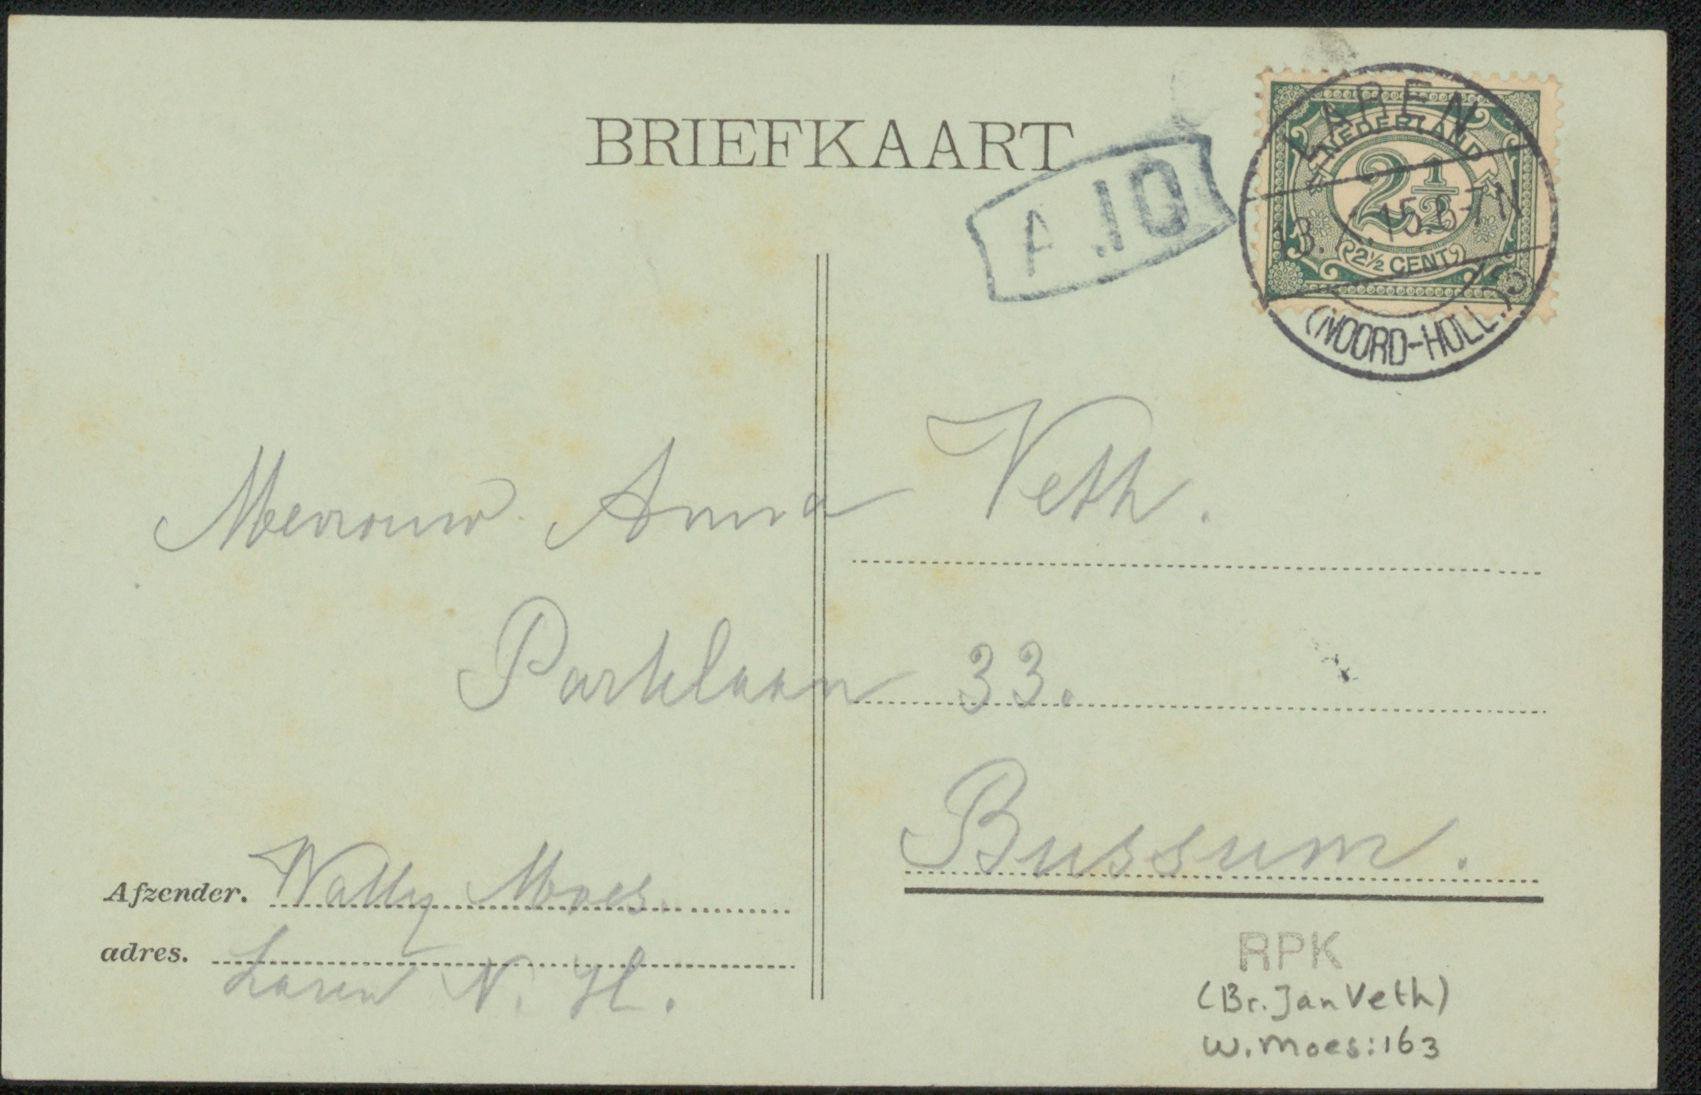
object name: postcard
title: Briefkaart aan Anna Dorothea Dirks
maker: wally moes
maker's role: draughtsman, print maker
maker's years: 1856-1918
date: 1915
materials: cardboard, pencil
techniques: writing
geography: laren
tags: the hague, painter, print maker, draughtsman, hendrik willem mesdag, artist, anna dorothea dirks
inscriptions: collector's mark: ‘RPK’